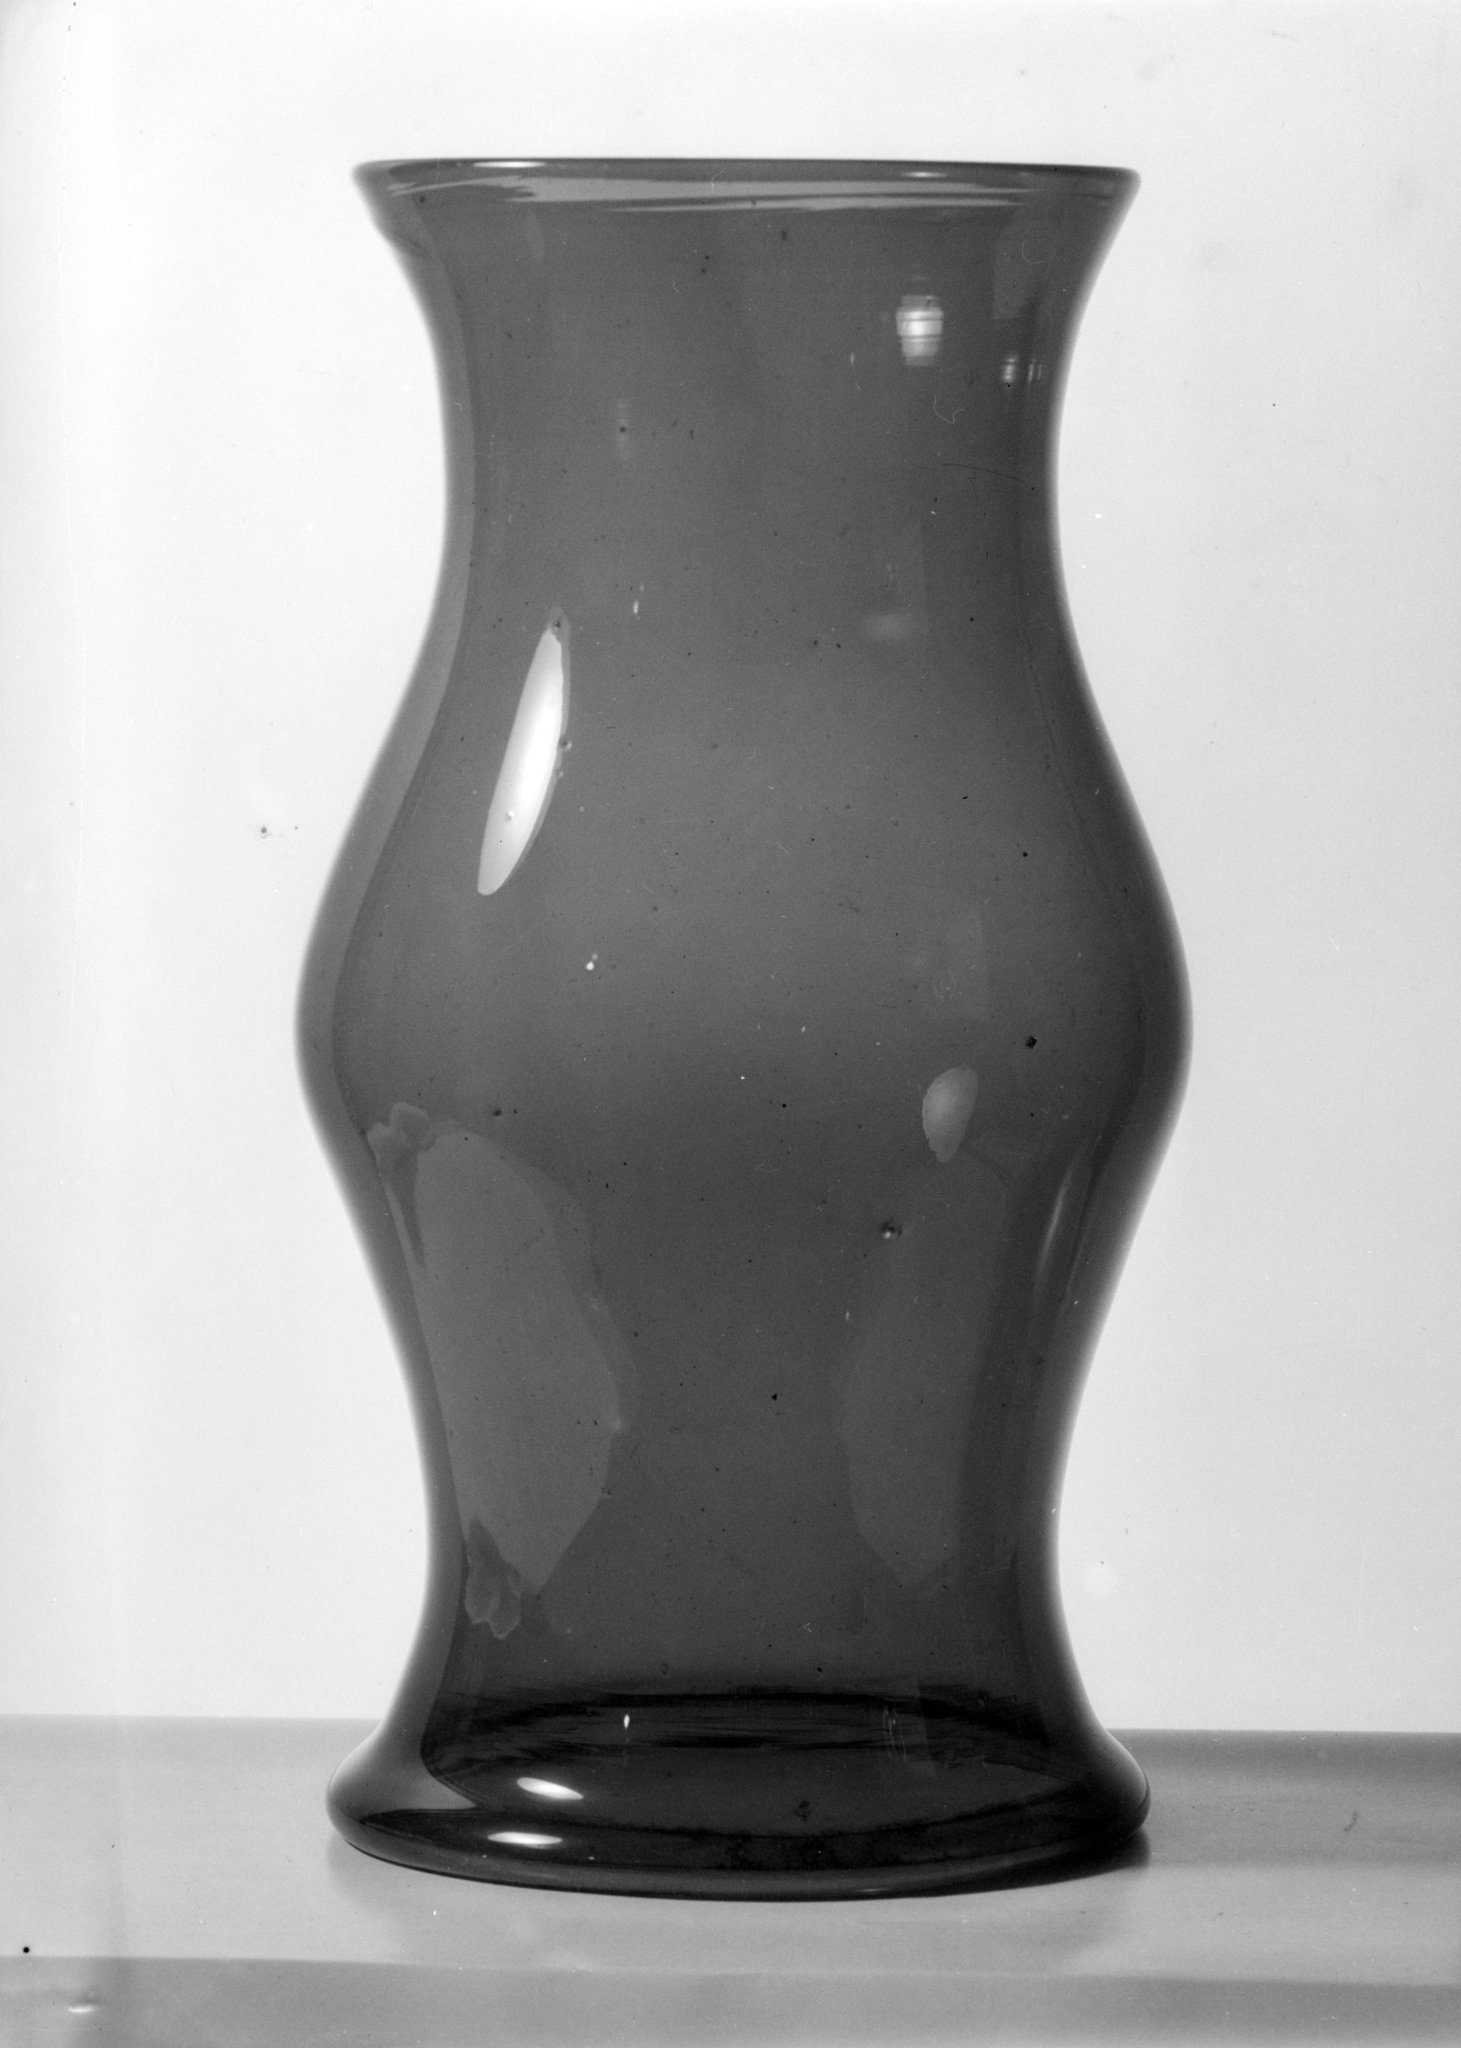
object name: hurricane shade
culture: american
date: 1800-1830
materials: gemstone, glass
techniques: glassblowing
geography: united states